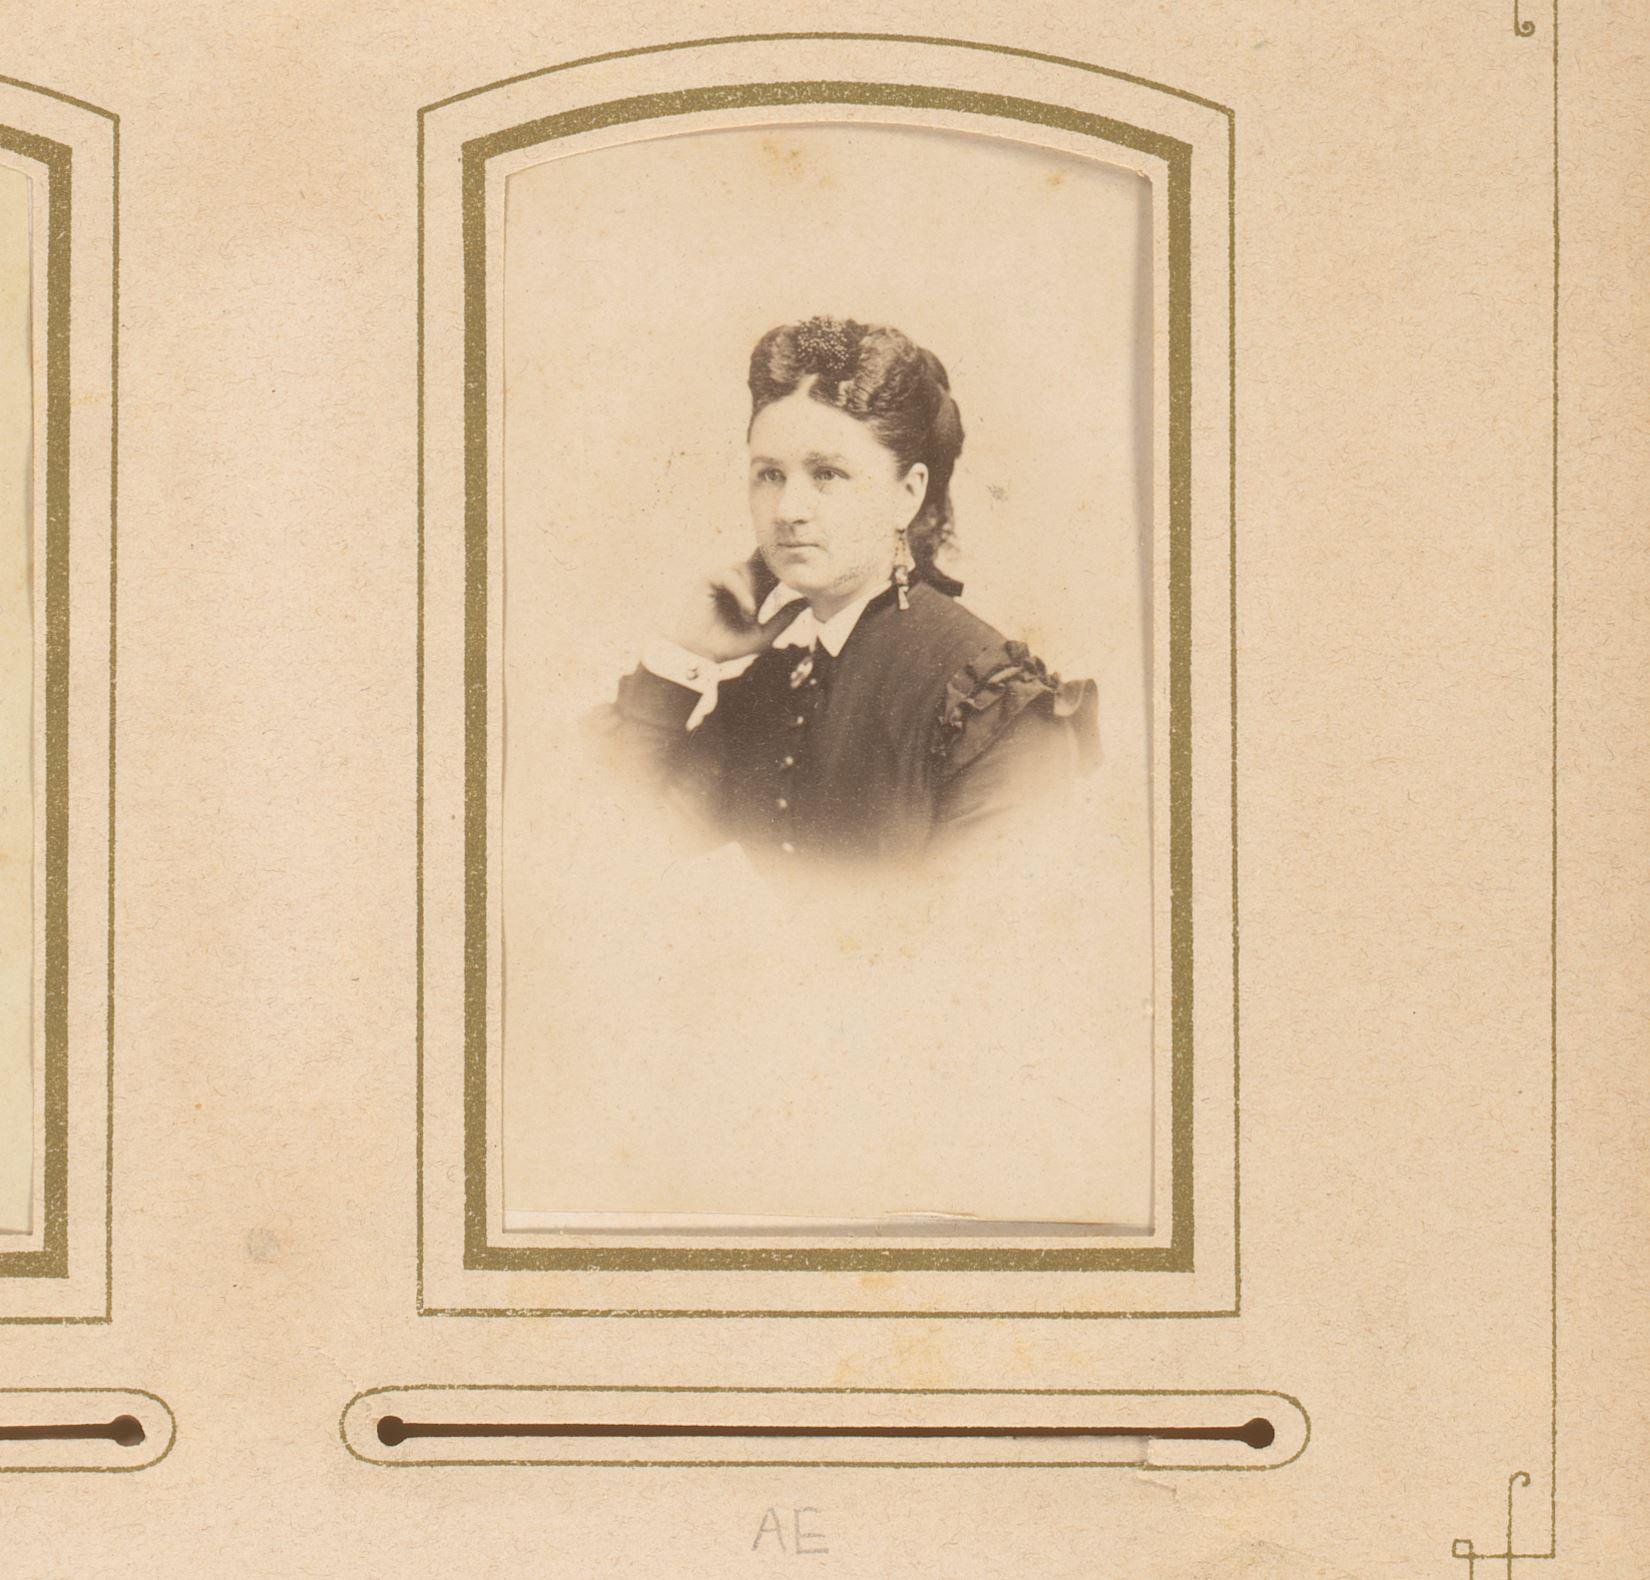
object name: photograph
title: Portret van een jonge vrouw met oorbellen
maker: egide-françois billotte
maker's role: fotograaf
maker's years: 1828-1911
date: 1865-1880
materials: cardboard, photographic support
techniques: albumen print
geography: brussels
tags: adolescent, young woman, maiden, historical persons - bb - woman, ear-rings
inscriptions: inscription: ‘ATELIER DE PHOTOGRAPHIE/ E. BILLOTTE,/ 4, Montagne aux Herbes Potagères,/ BRUXELLES/ Anciennement rue de la Reine.’